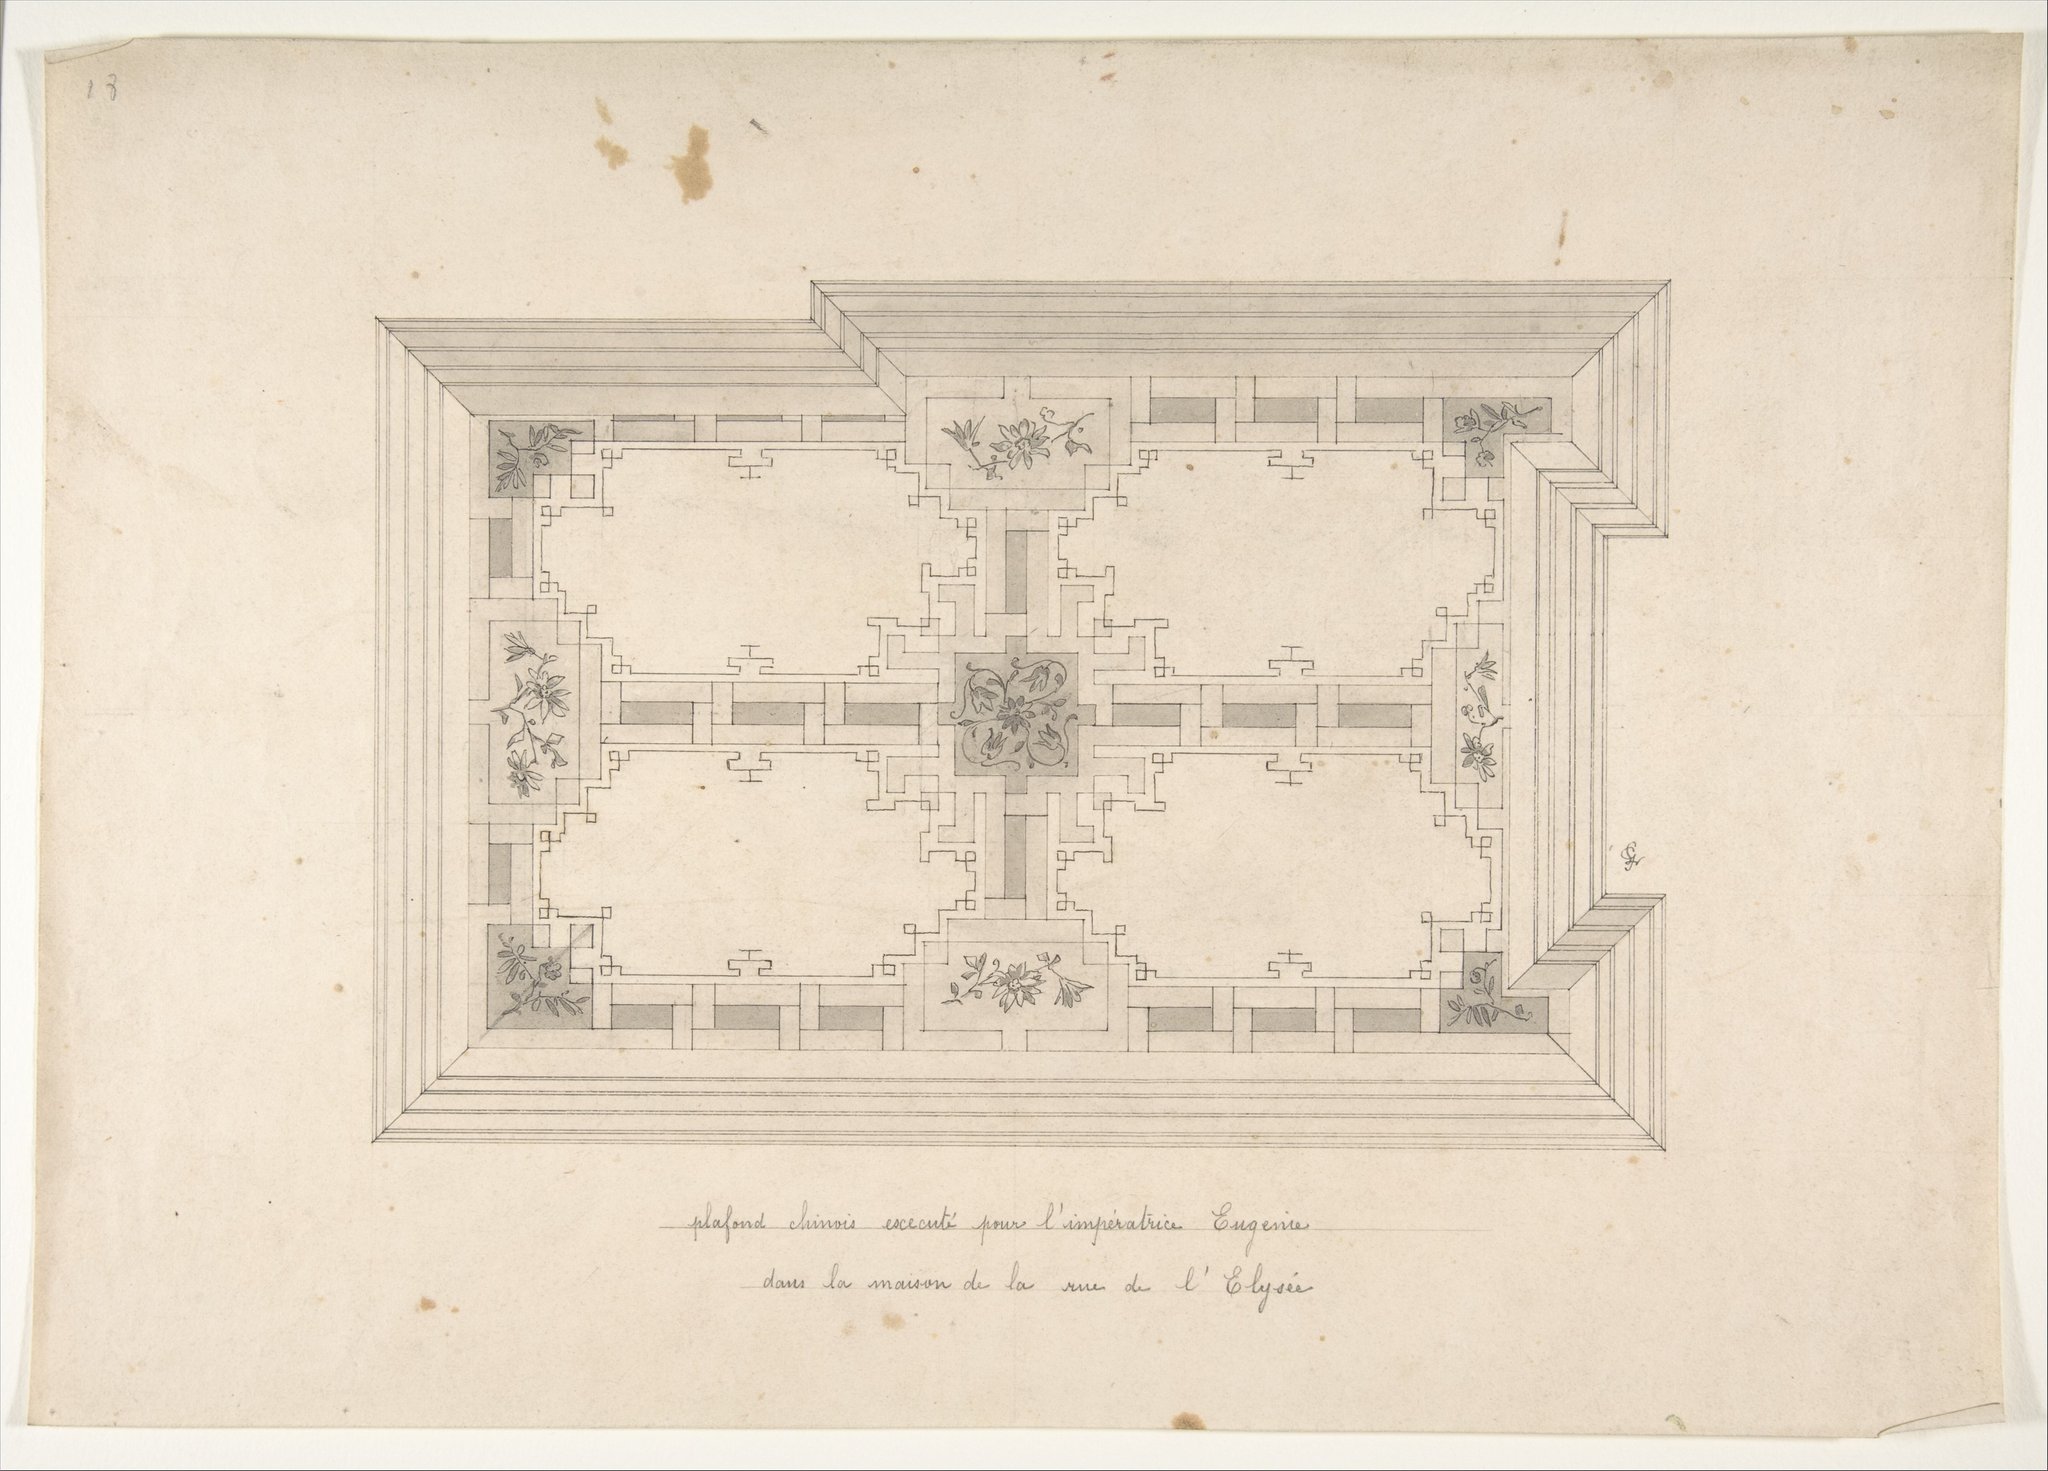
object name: drawing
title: Design for Ceiling in Chinois Style, Empress Eugénie's Hotel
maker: jules-edmond-charles lachaise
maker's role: artist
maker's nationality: french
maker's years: 1897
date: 1851-1900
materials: ink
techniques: brush, pen, wash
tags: architecture,ceilings